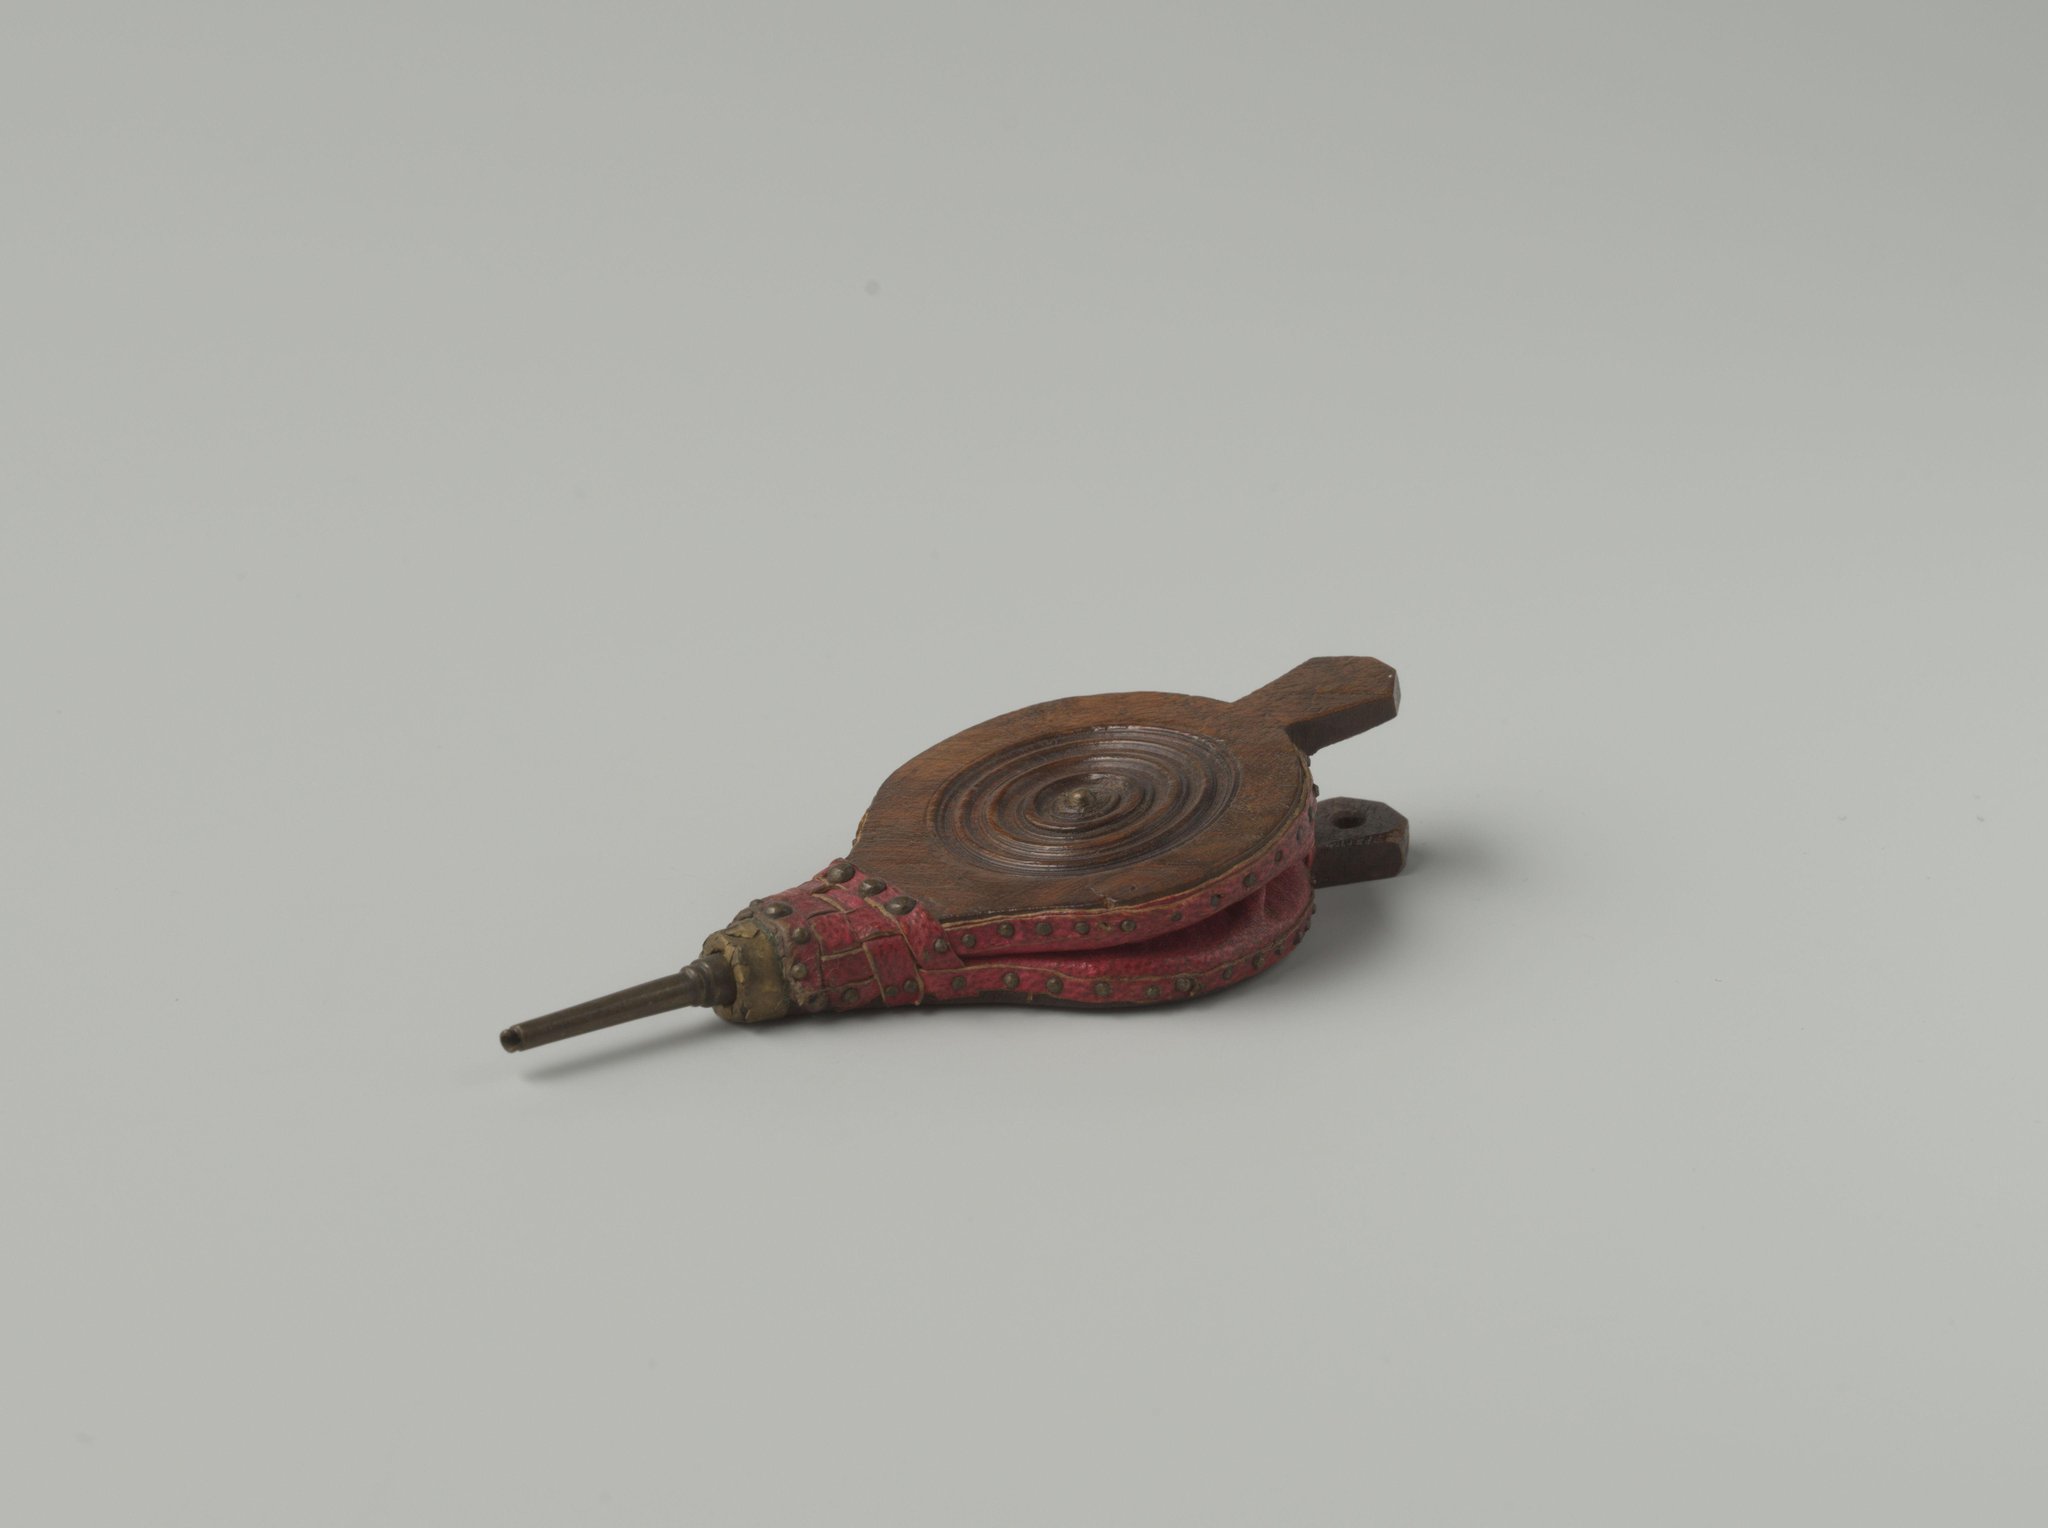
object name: heating system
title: Blaasbalg, bestaande uit notenhouten onder- en bovenblad, waartussen rozerood leer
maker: Anonymous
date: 1690-1710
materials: brass, wood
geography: amsterdam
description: Blaasbalg, bestaande uit notenhouten onder- en bovenblad waartussen roze-rood leer; bovenblad met versiering van concentrisch gedraaide ringen, in onderblad drie luchtgaten. Blaaspijp van koper. Het leer is met koperen spijkertjes op de bladen bevestigd en is ter hoogte van het scharnier boven de blaaspijp in ruitpatroon gevlochten.